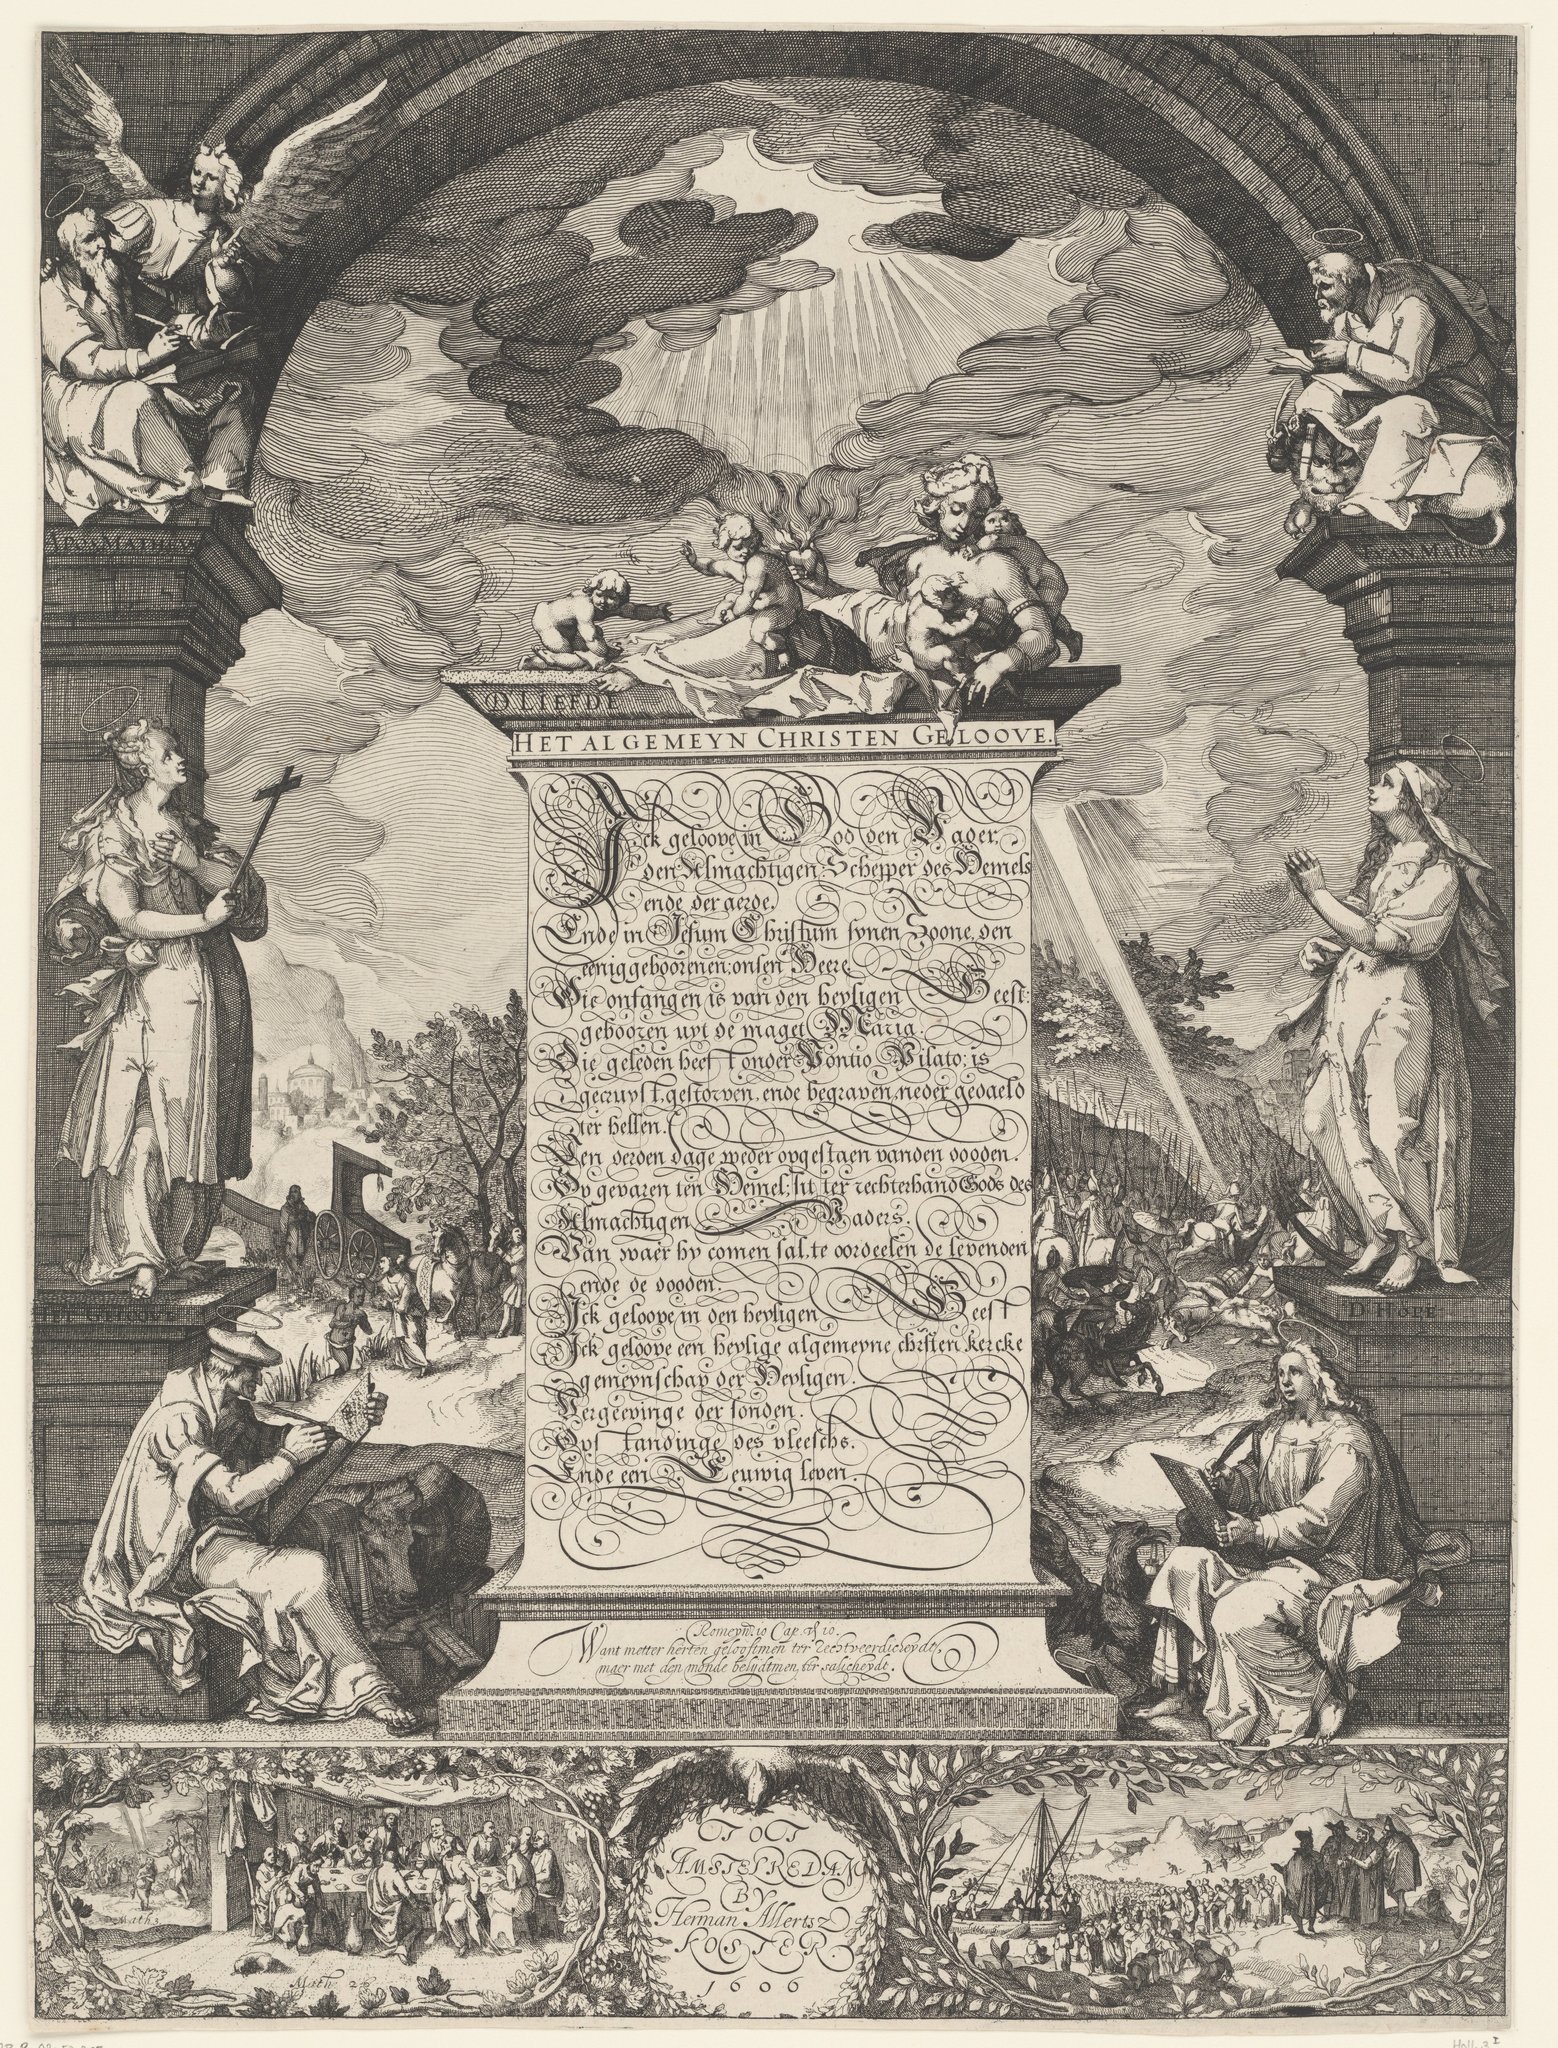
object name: print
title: Het algemeyn christen geloove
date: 1606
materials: paper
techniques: etching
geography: amsterdam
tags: the episode of the last supper, the three theological virtues, the miraculous draught of fishes (before the resurrection) on the lake of gennesaret (sea of galilee); james and john helping to bring in the nets (luke 5:1-11), the evangelists writing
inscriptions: collector's mark: Lugt 240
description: De vier evangelisten samen met de goddelijke deugden rond een grote zuil met daarop de Christelijke geloofsbelijdenis. Onderaan de prent zijn diverse scènes uit het Nieuwe Testament weergegeven: de doop van Christus, het Laatste Avondmaal en de wonderbaarlijke visvangst.